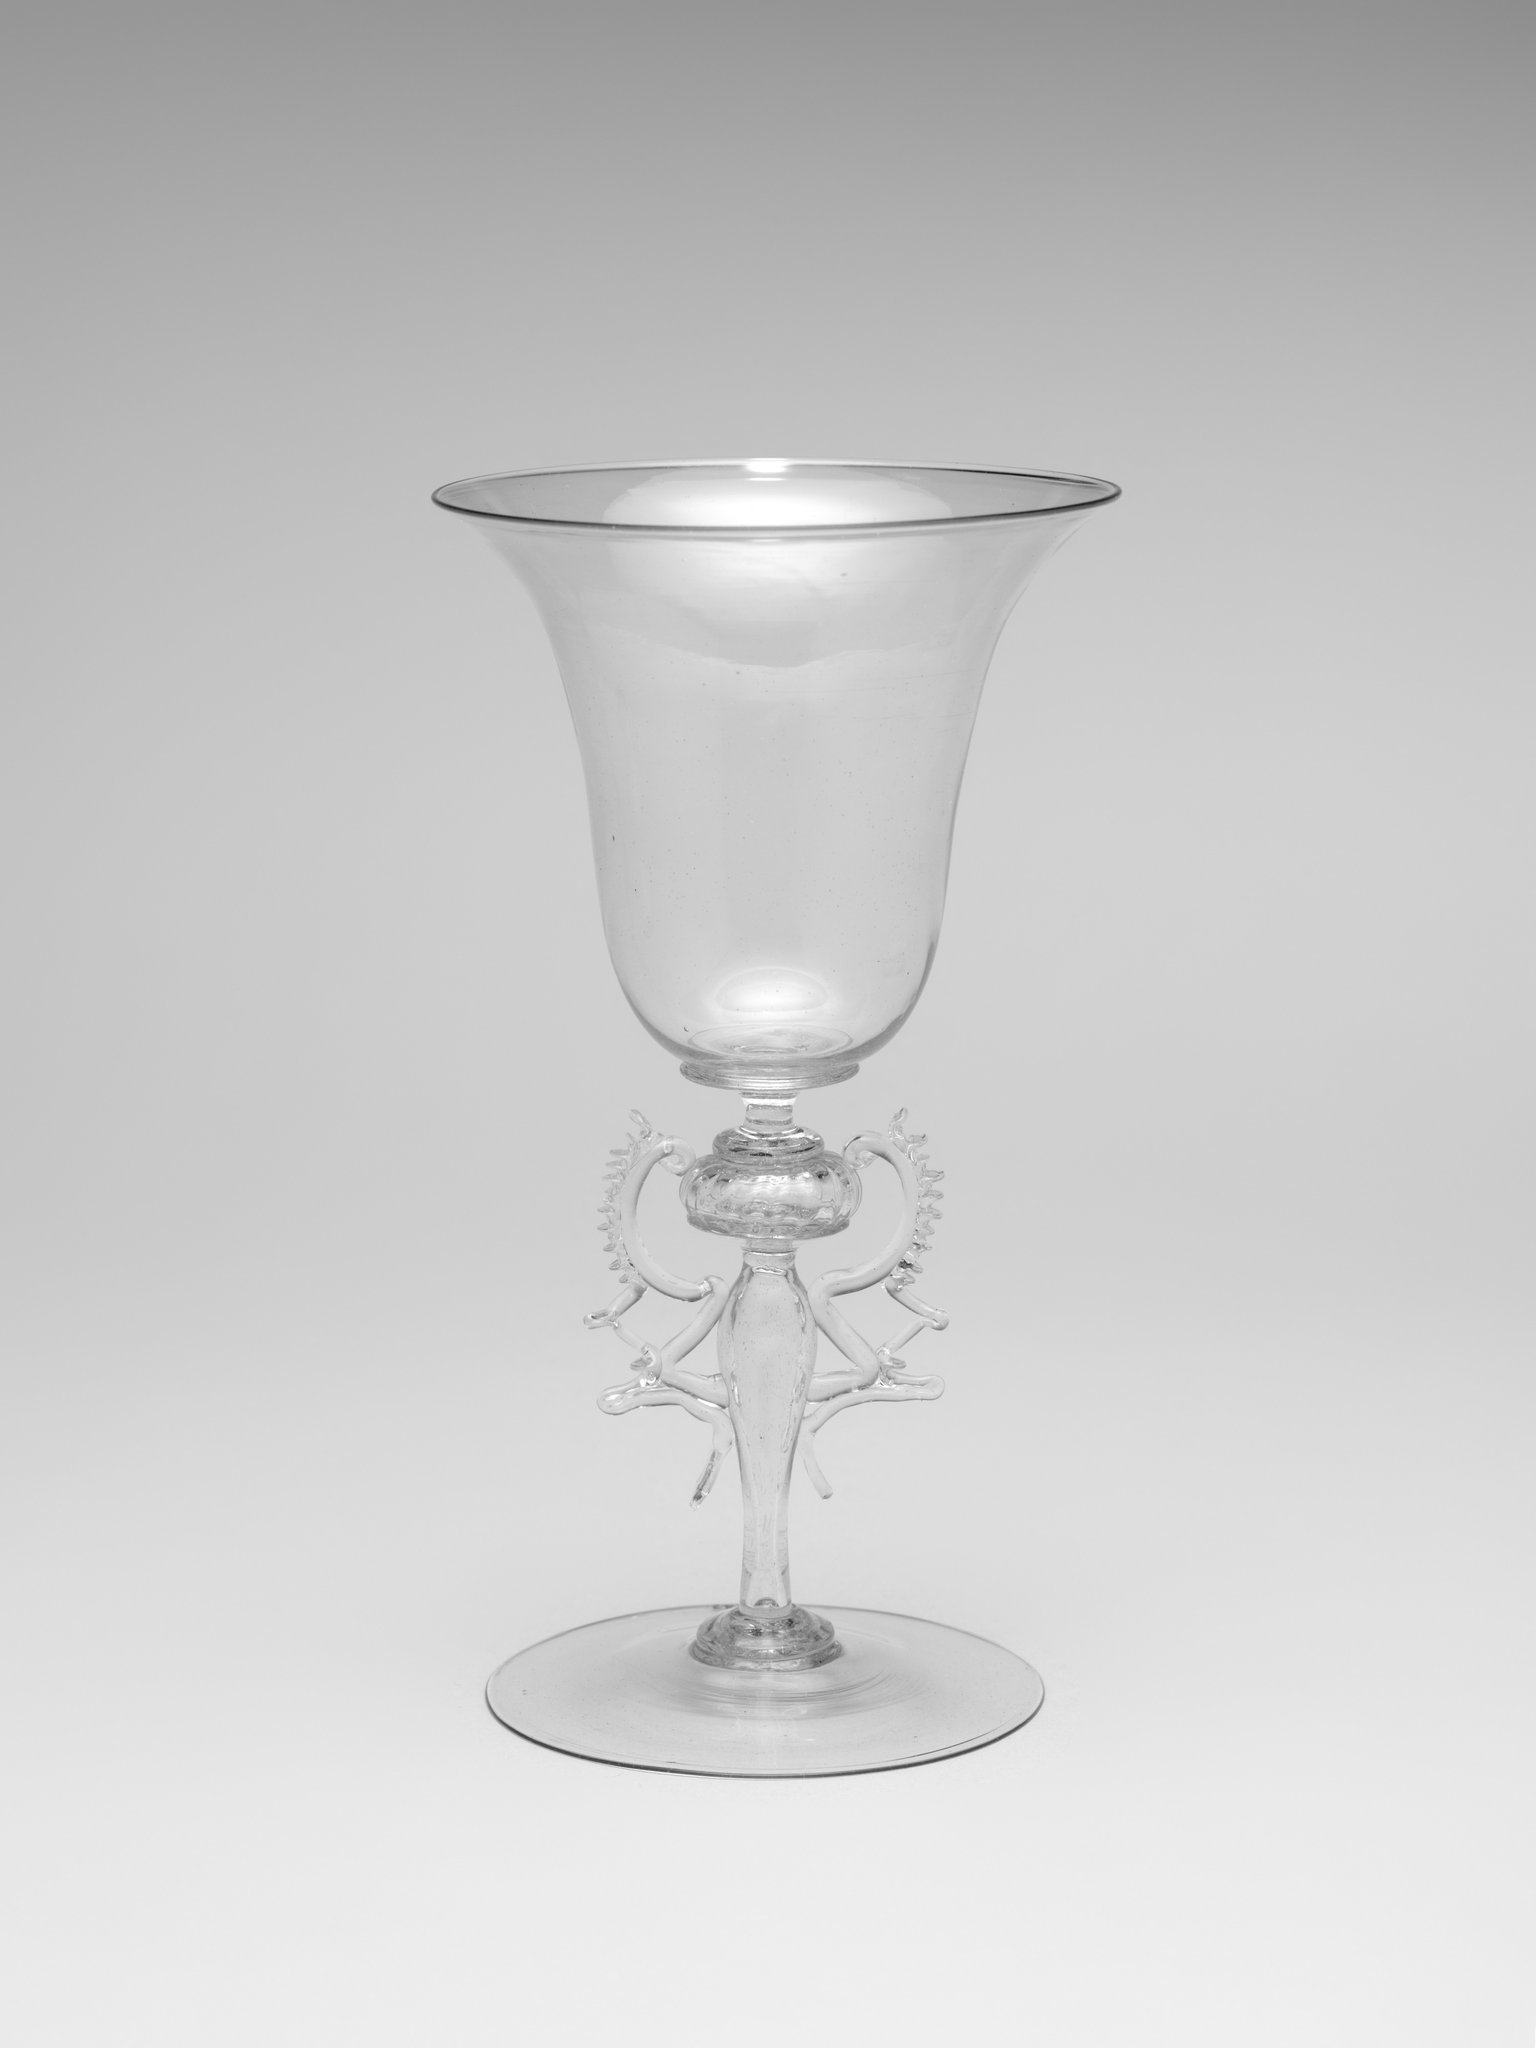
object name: wineglass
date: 1501-1600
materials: glass